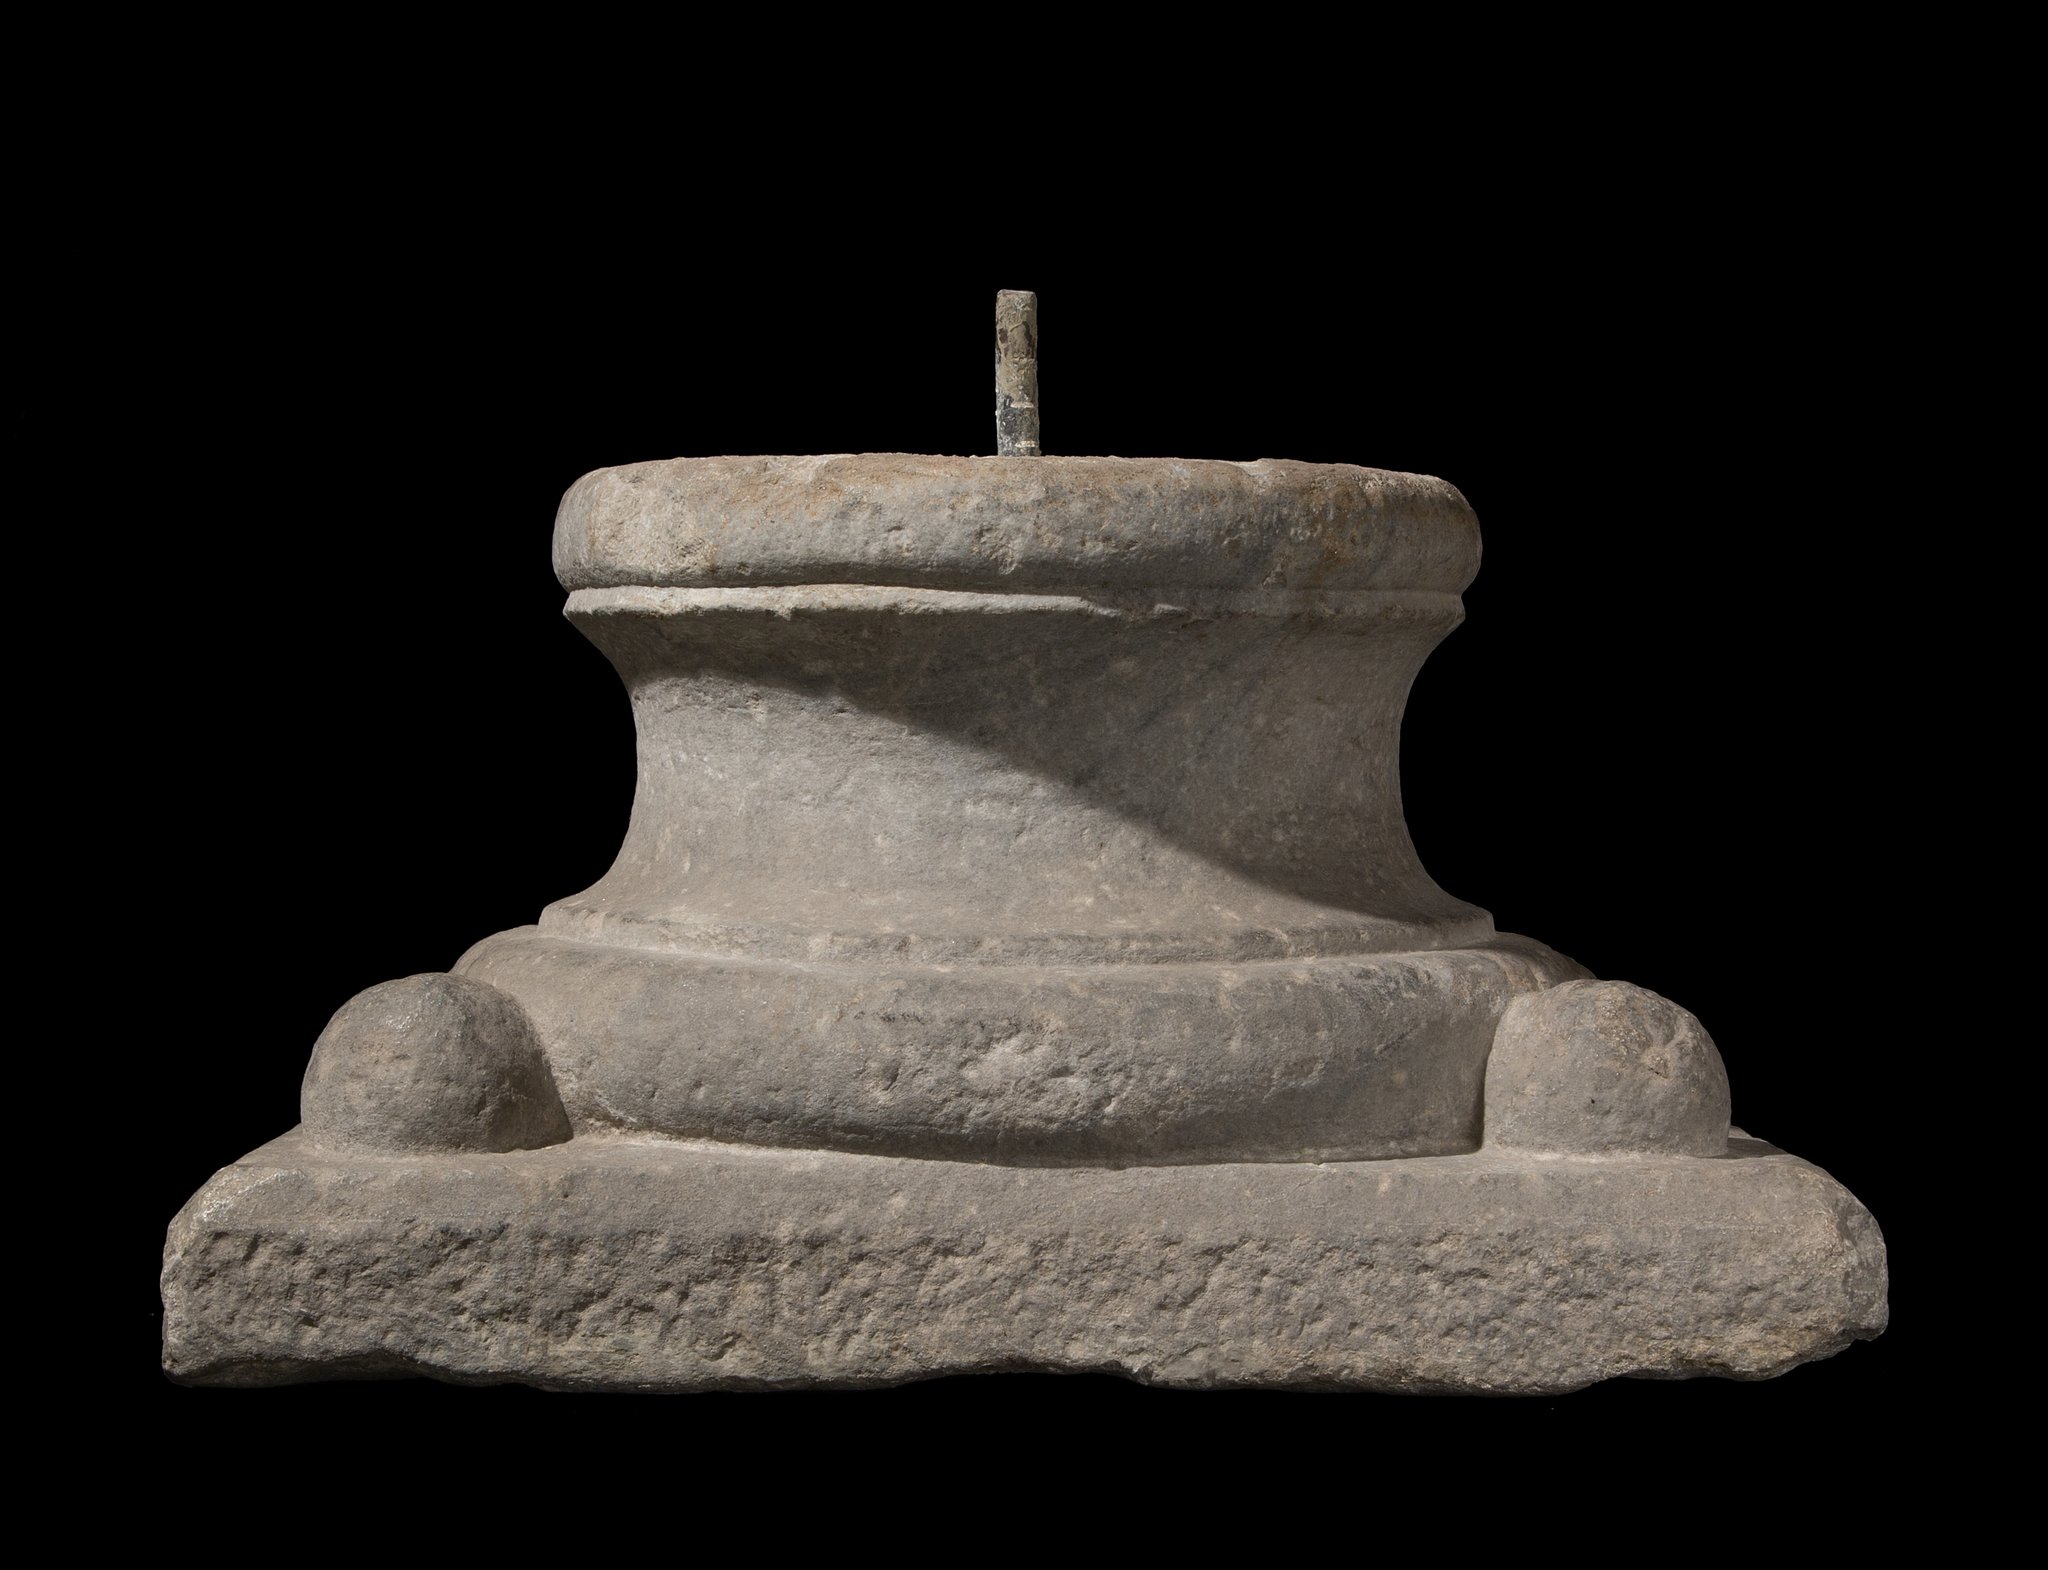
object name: base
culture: catalan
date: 1134-1166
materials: marble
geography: france